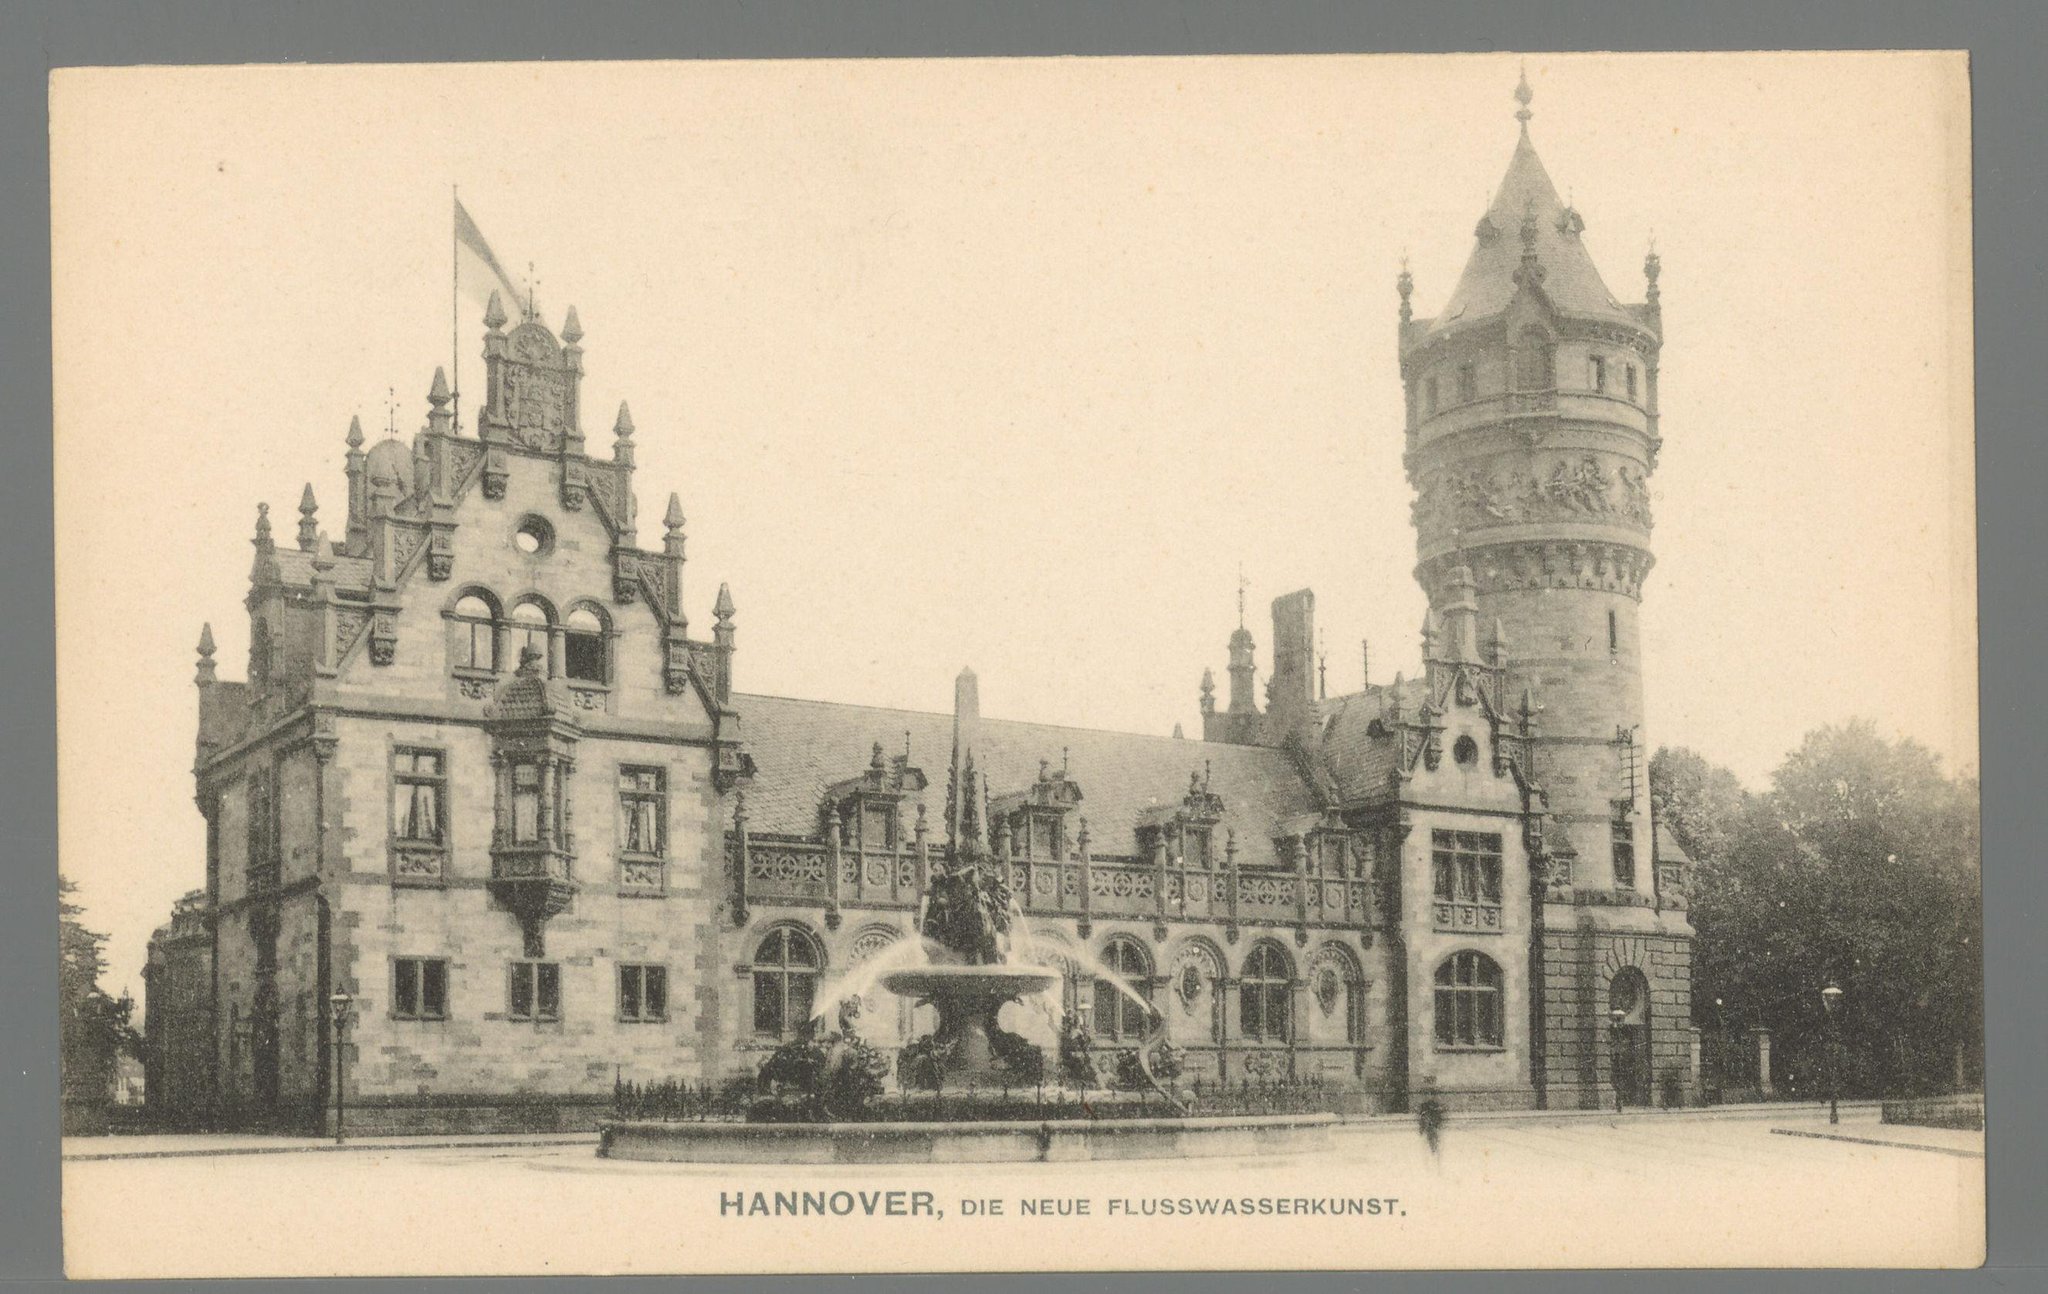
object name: photomechanical print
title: Hannover, die neue Flusswasserkunst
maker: Anonymous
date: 1905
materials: cardboard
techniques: photograph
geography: darmstadt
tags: castle, ornamental fountain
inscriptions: date